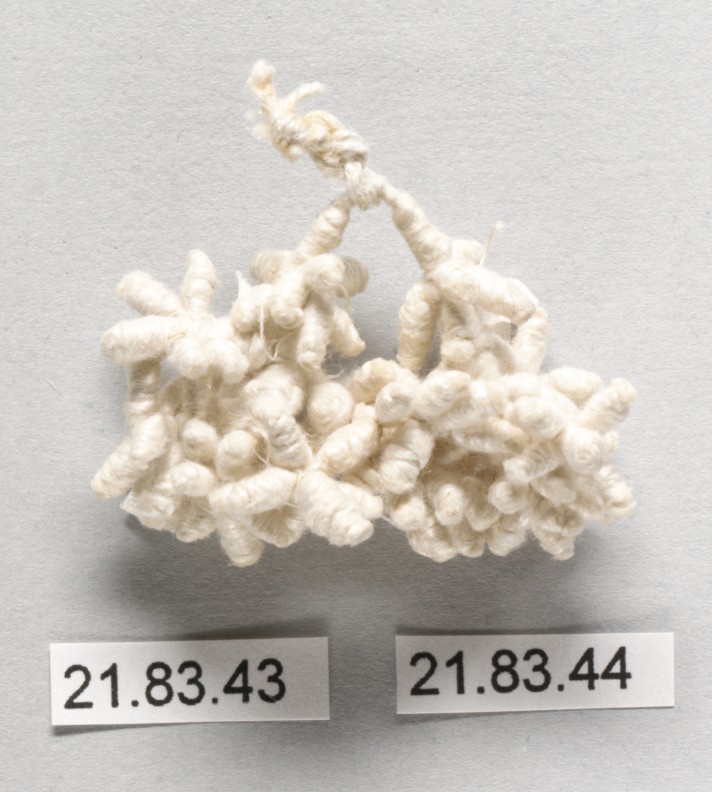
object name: tassel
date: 1601-1700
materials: linen